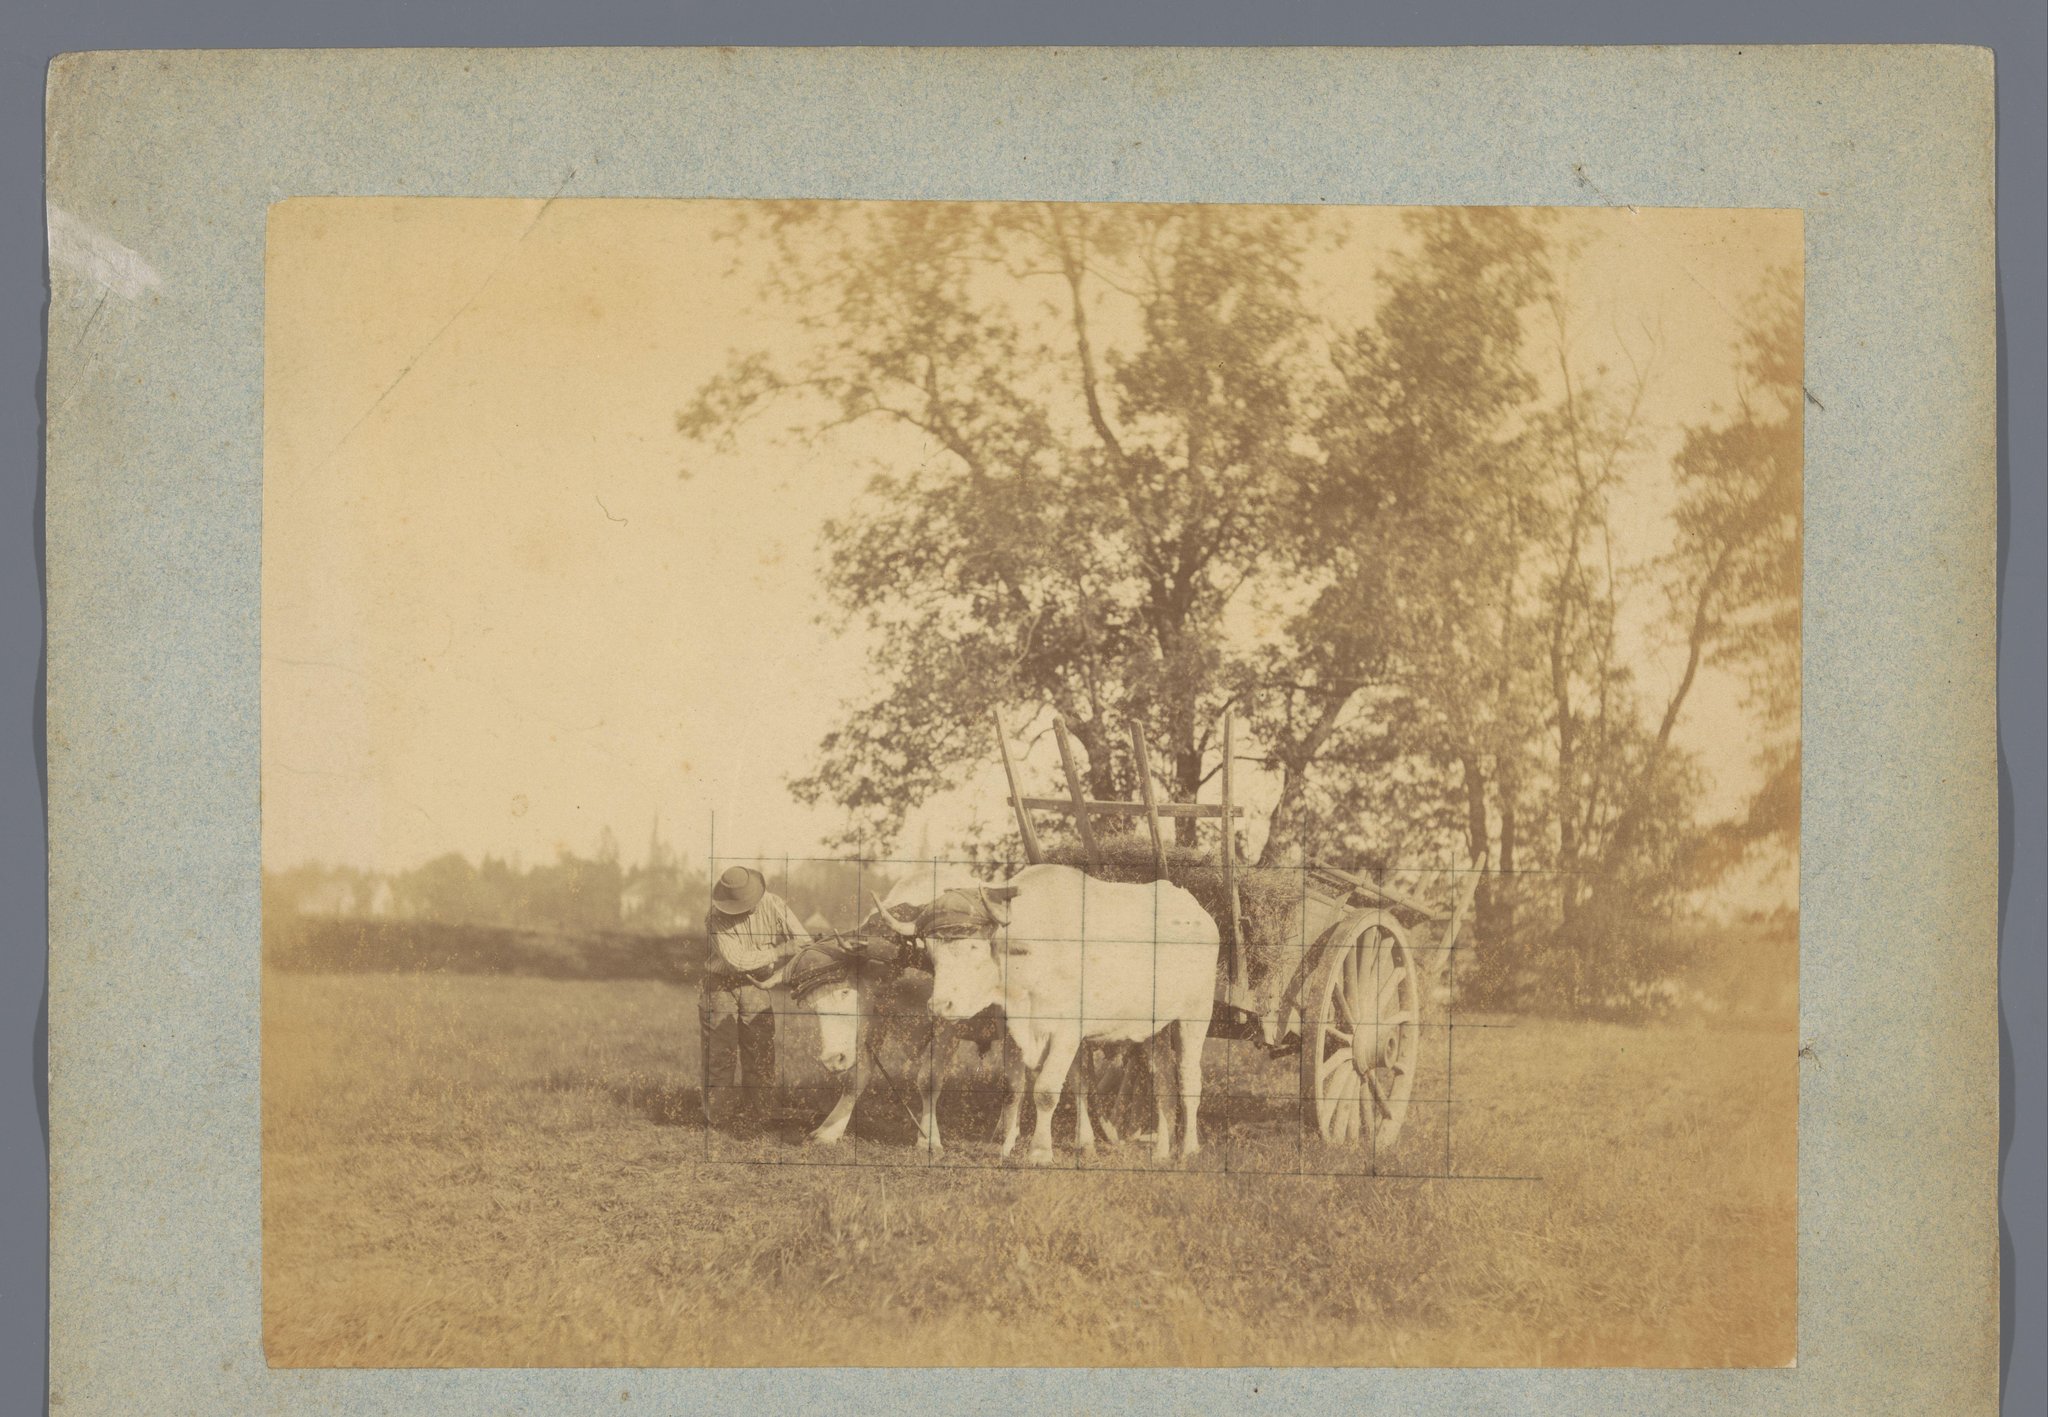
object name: photograph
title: Ossenkar in landschap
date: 1887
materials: paper, pencil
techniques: albumen print, drawing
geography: france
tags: ox, agriculture, two-wheeled vehicle drawn by two animals, france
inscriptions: stamp: ‘Documents Artistiques en Photographie/ Paris/ H. Vargenau/ 52, Rue Notre/ Dame de Lorette’, stamp: ‘Photographie Artistique/ A. Foncelle/ 6, Rue de Seine, 6/ Paris’, inscription: ‘Ing.[?]/ 30/ L. de Vinci/ 125’